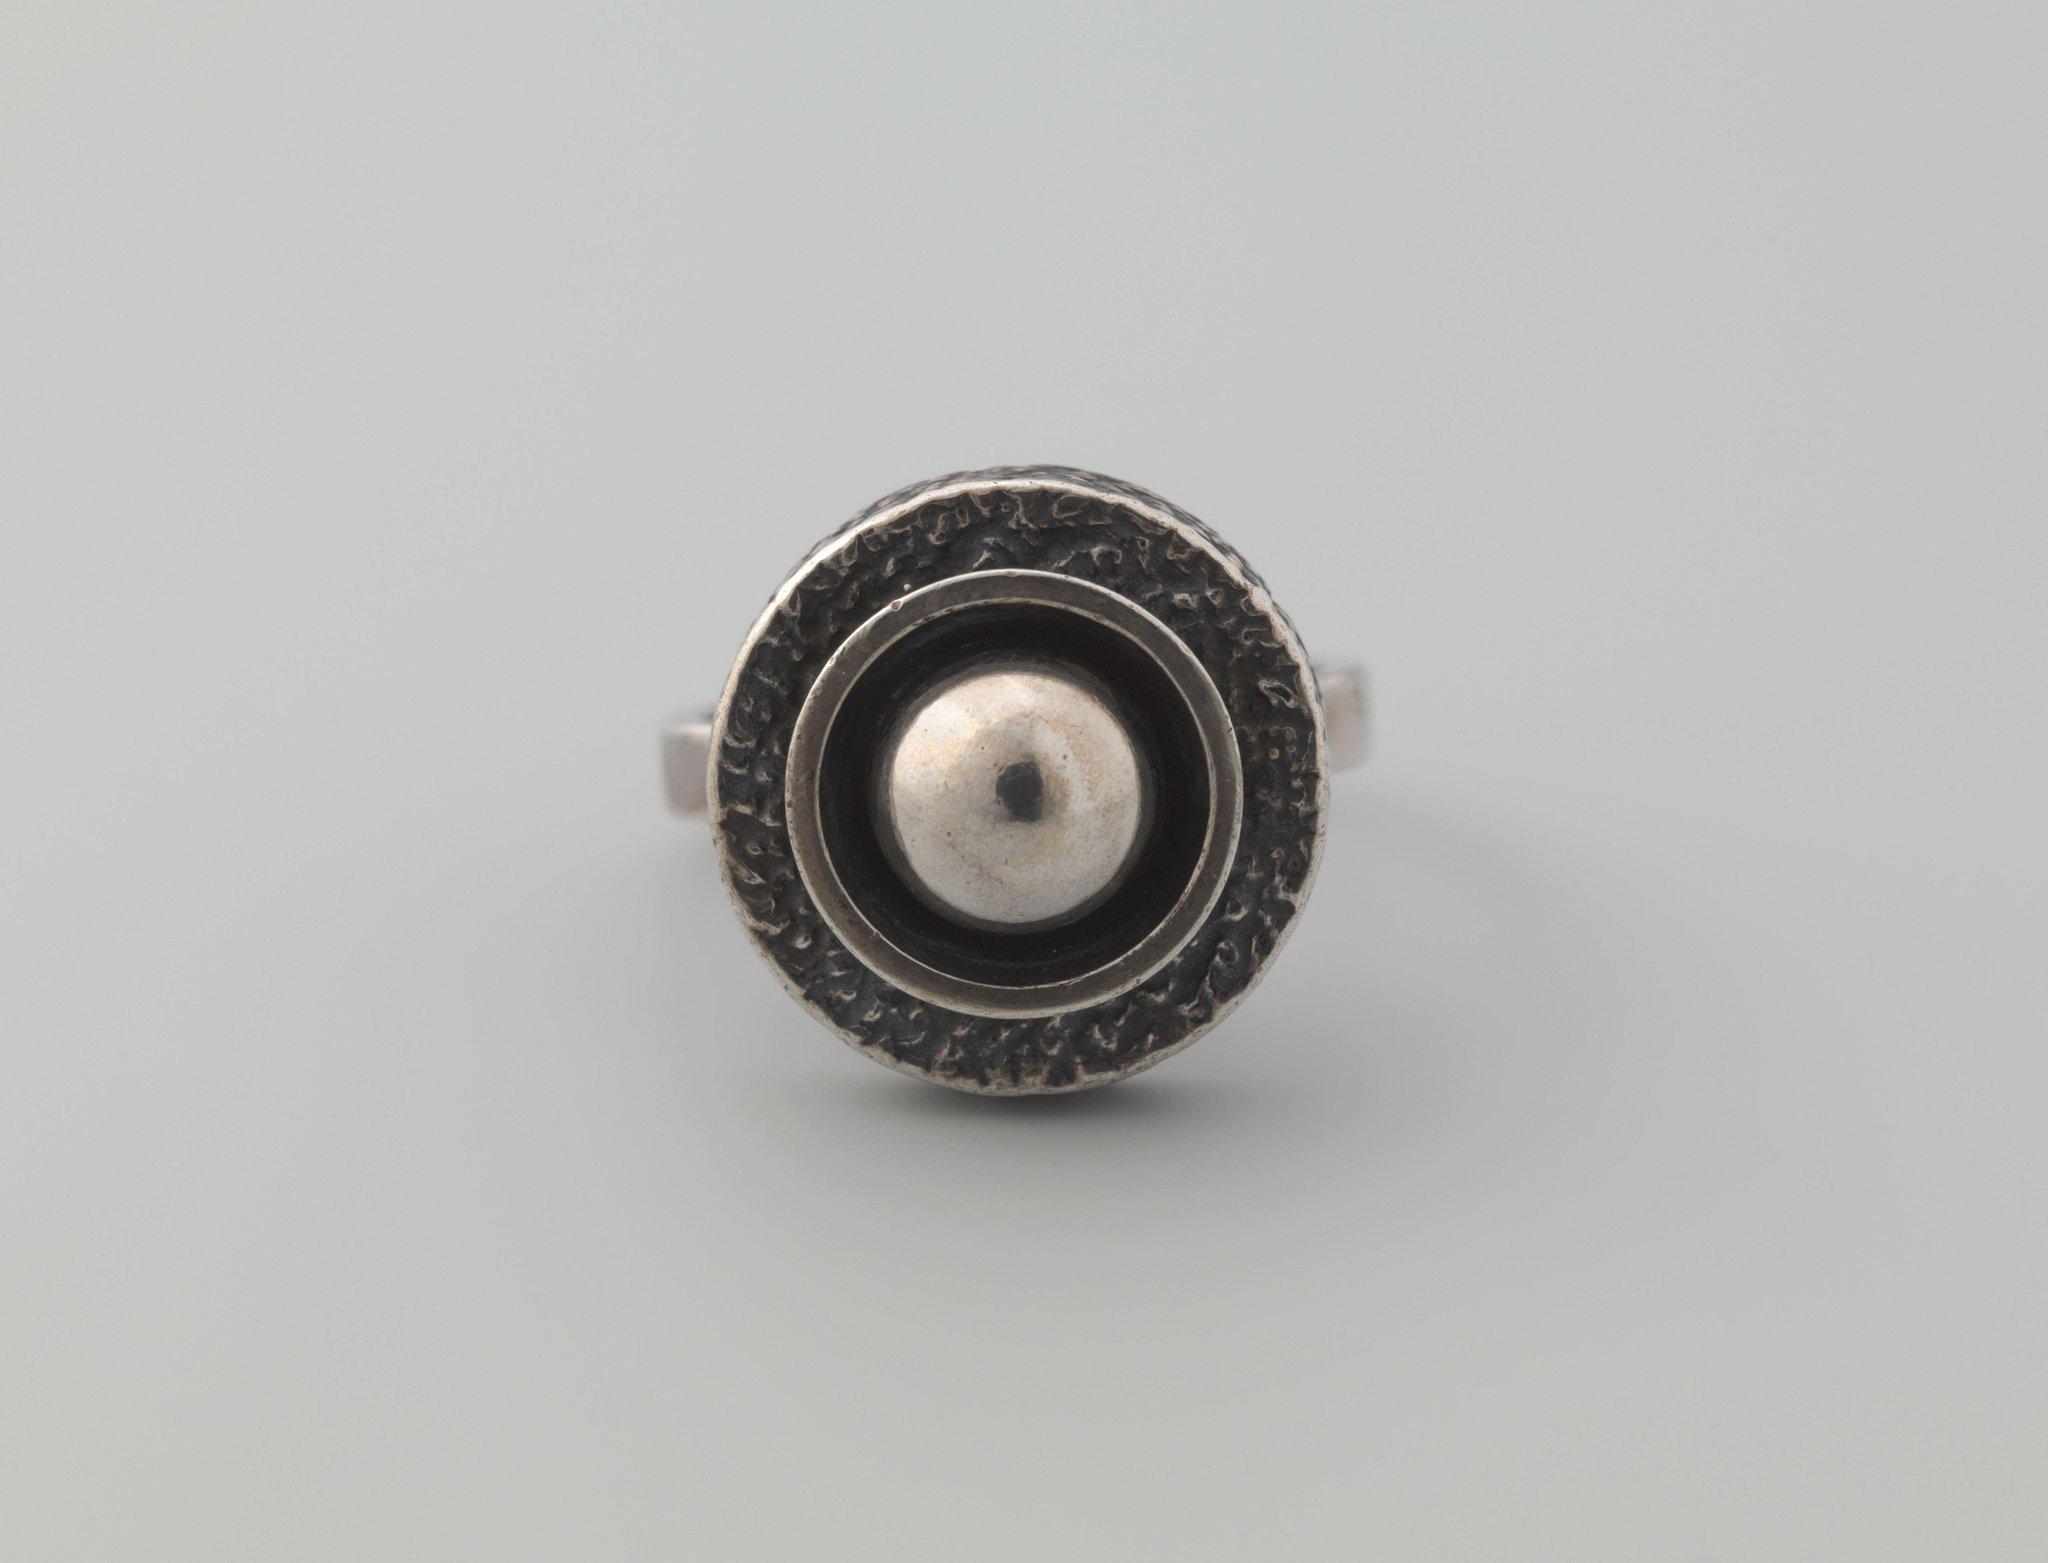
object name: ring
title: Tienerring met ronde knop van zilver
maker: Anonymous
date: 1960-1970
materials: silver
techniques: blackening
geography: schoonhoven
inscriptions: maker's mark: ‘N 10’, alloy mark: ‘zwaard 835’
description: Tienerring met ronde knop van zilver. De knop bestaat uit cirkels in verschillende texturen. De buitenste cirkel is ruw en gezwart, daarbinnen een gladde cirkel, daarbinnen een gezwarte en daarin tenslotte een poli stip.